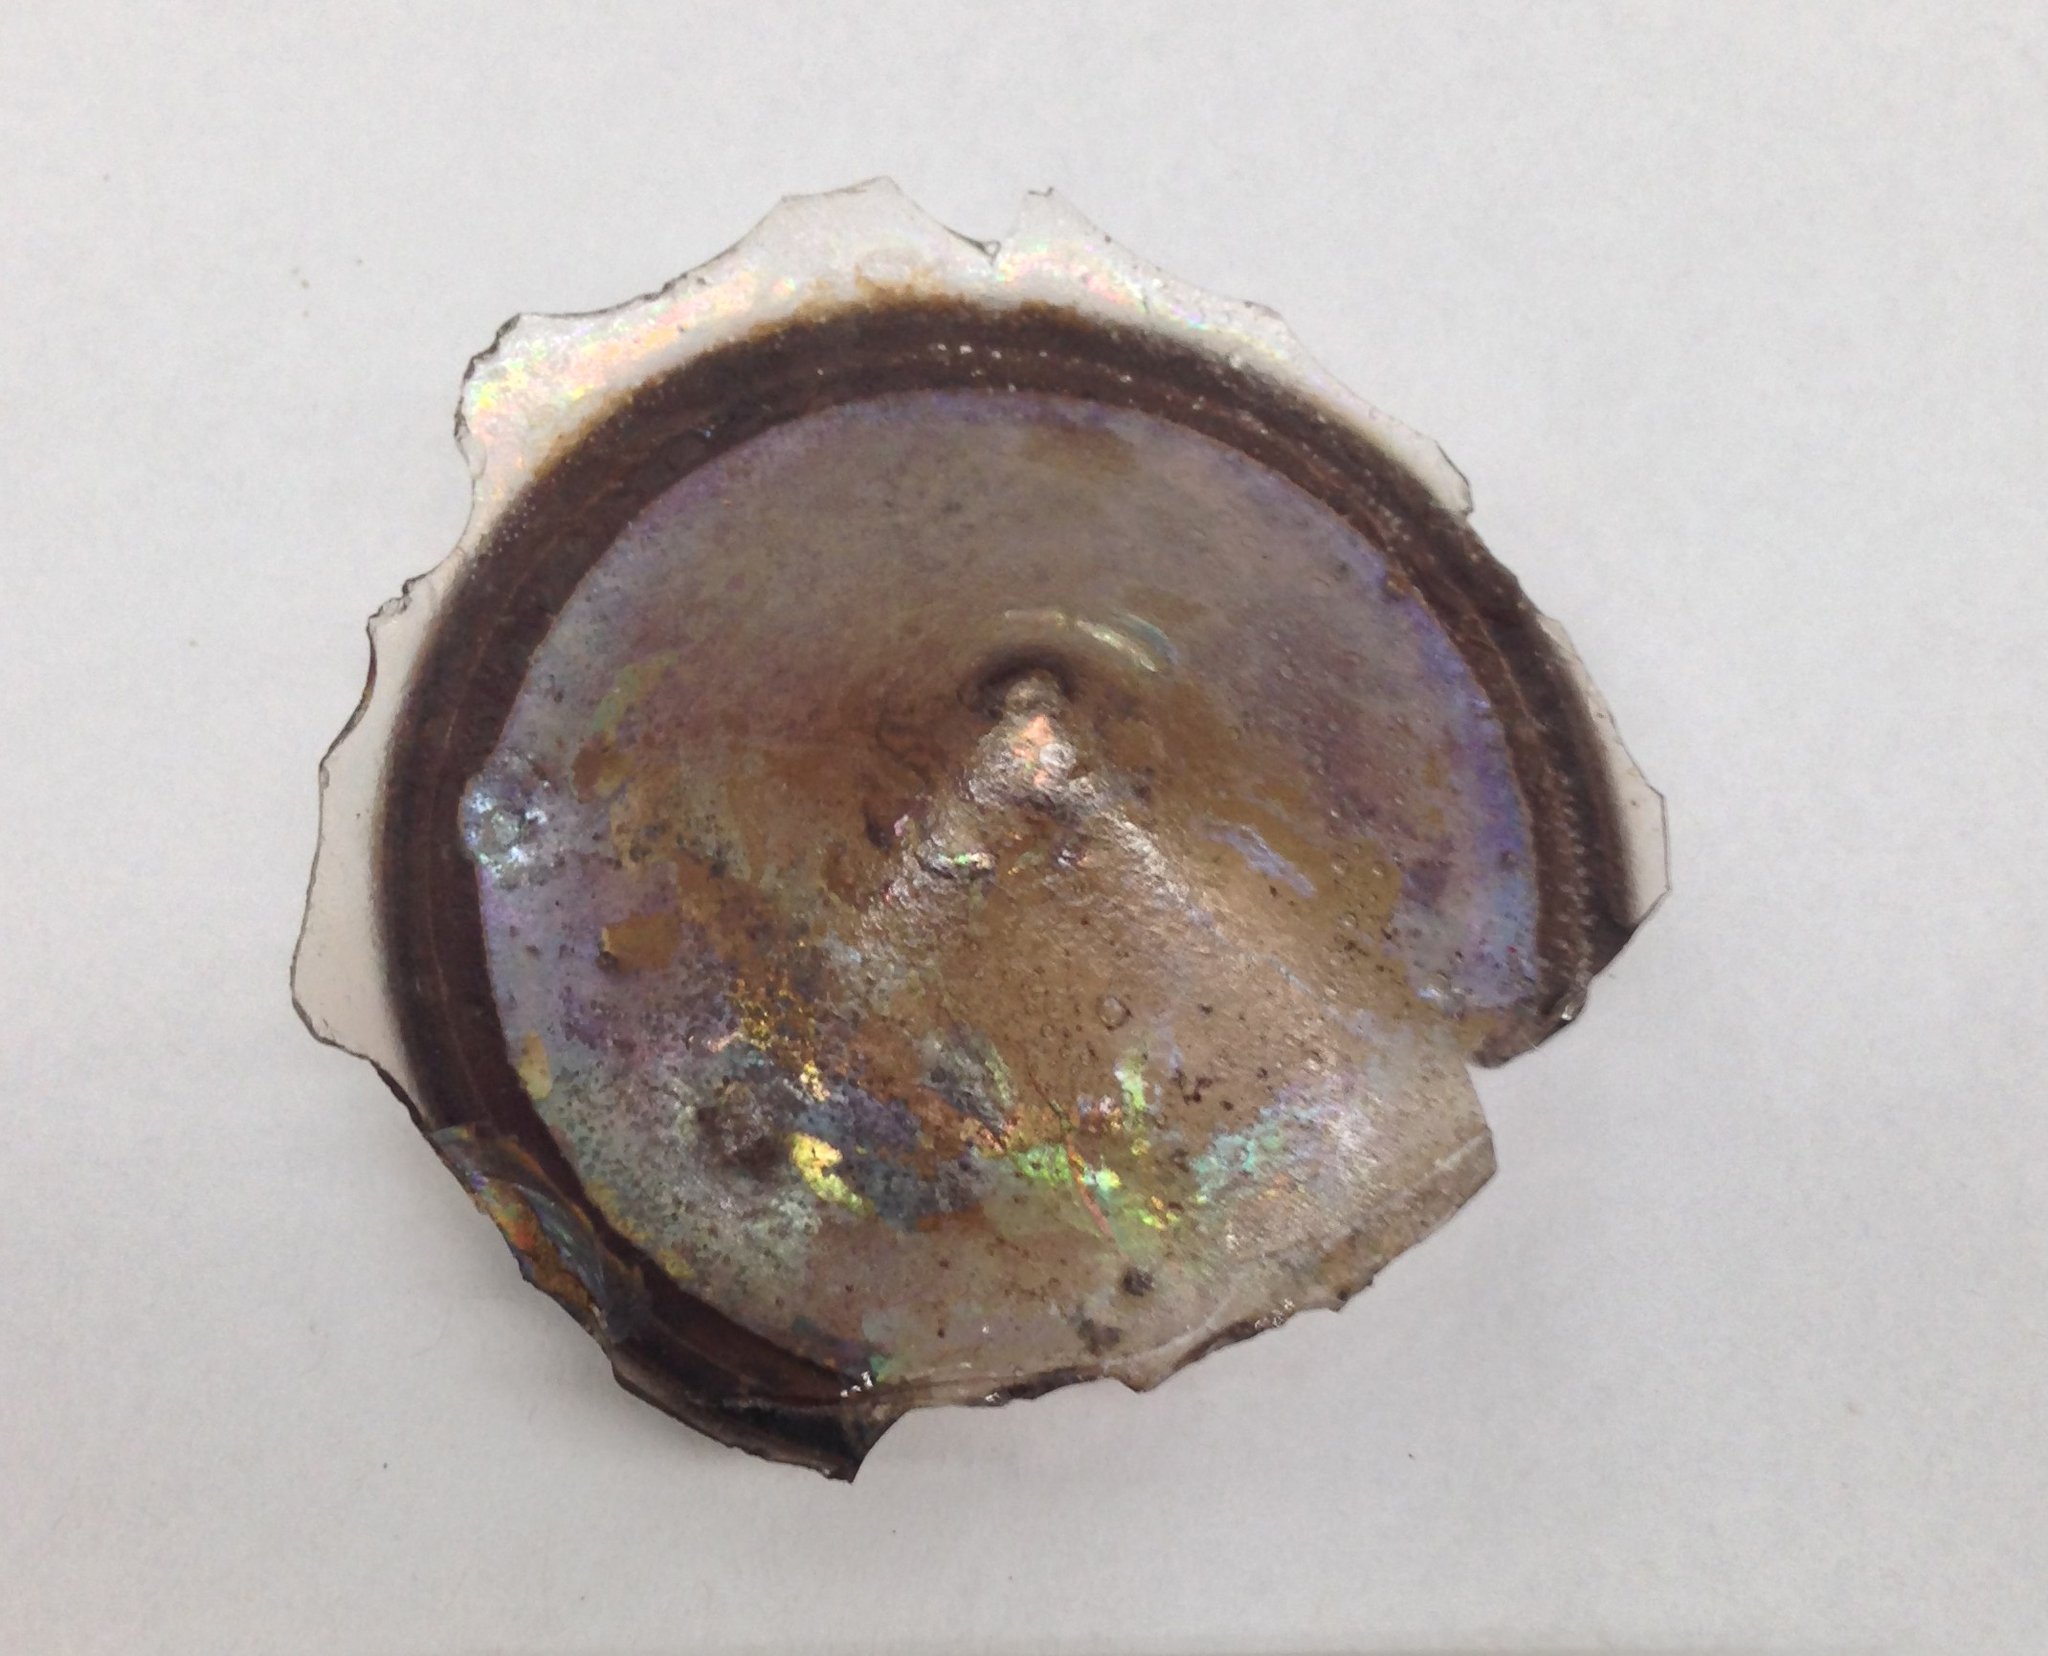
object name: glass fragment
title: Fragment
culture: european or middle eastern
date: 1150-1250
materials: ceramic, glass